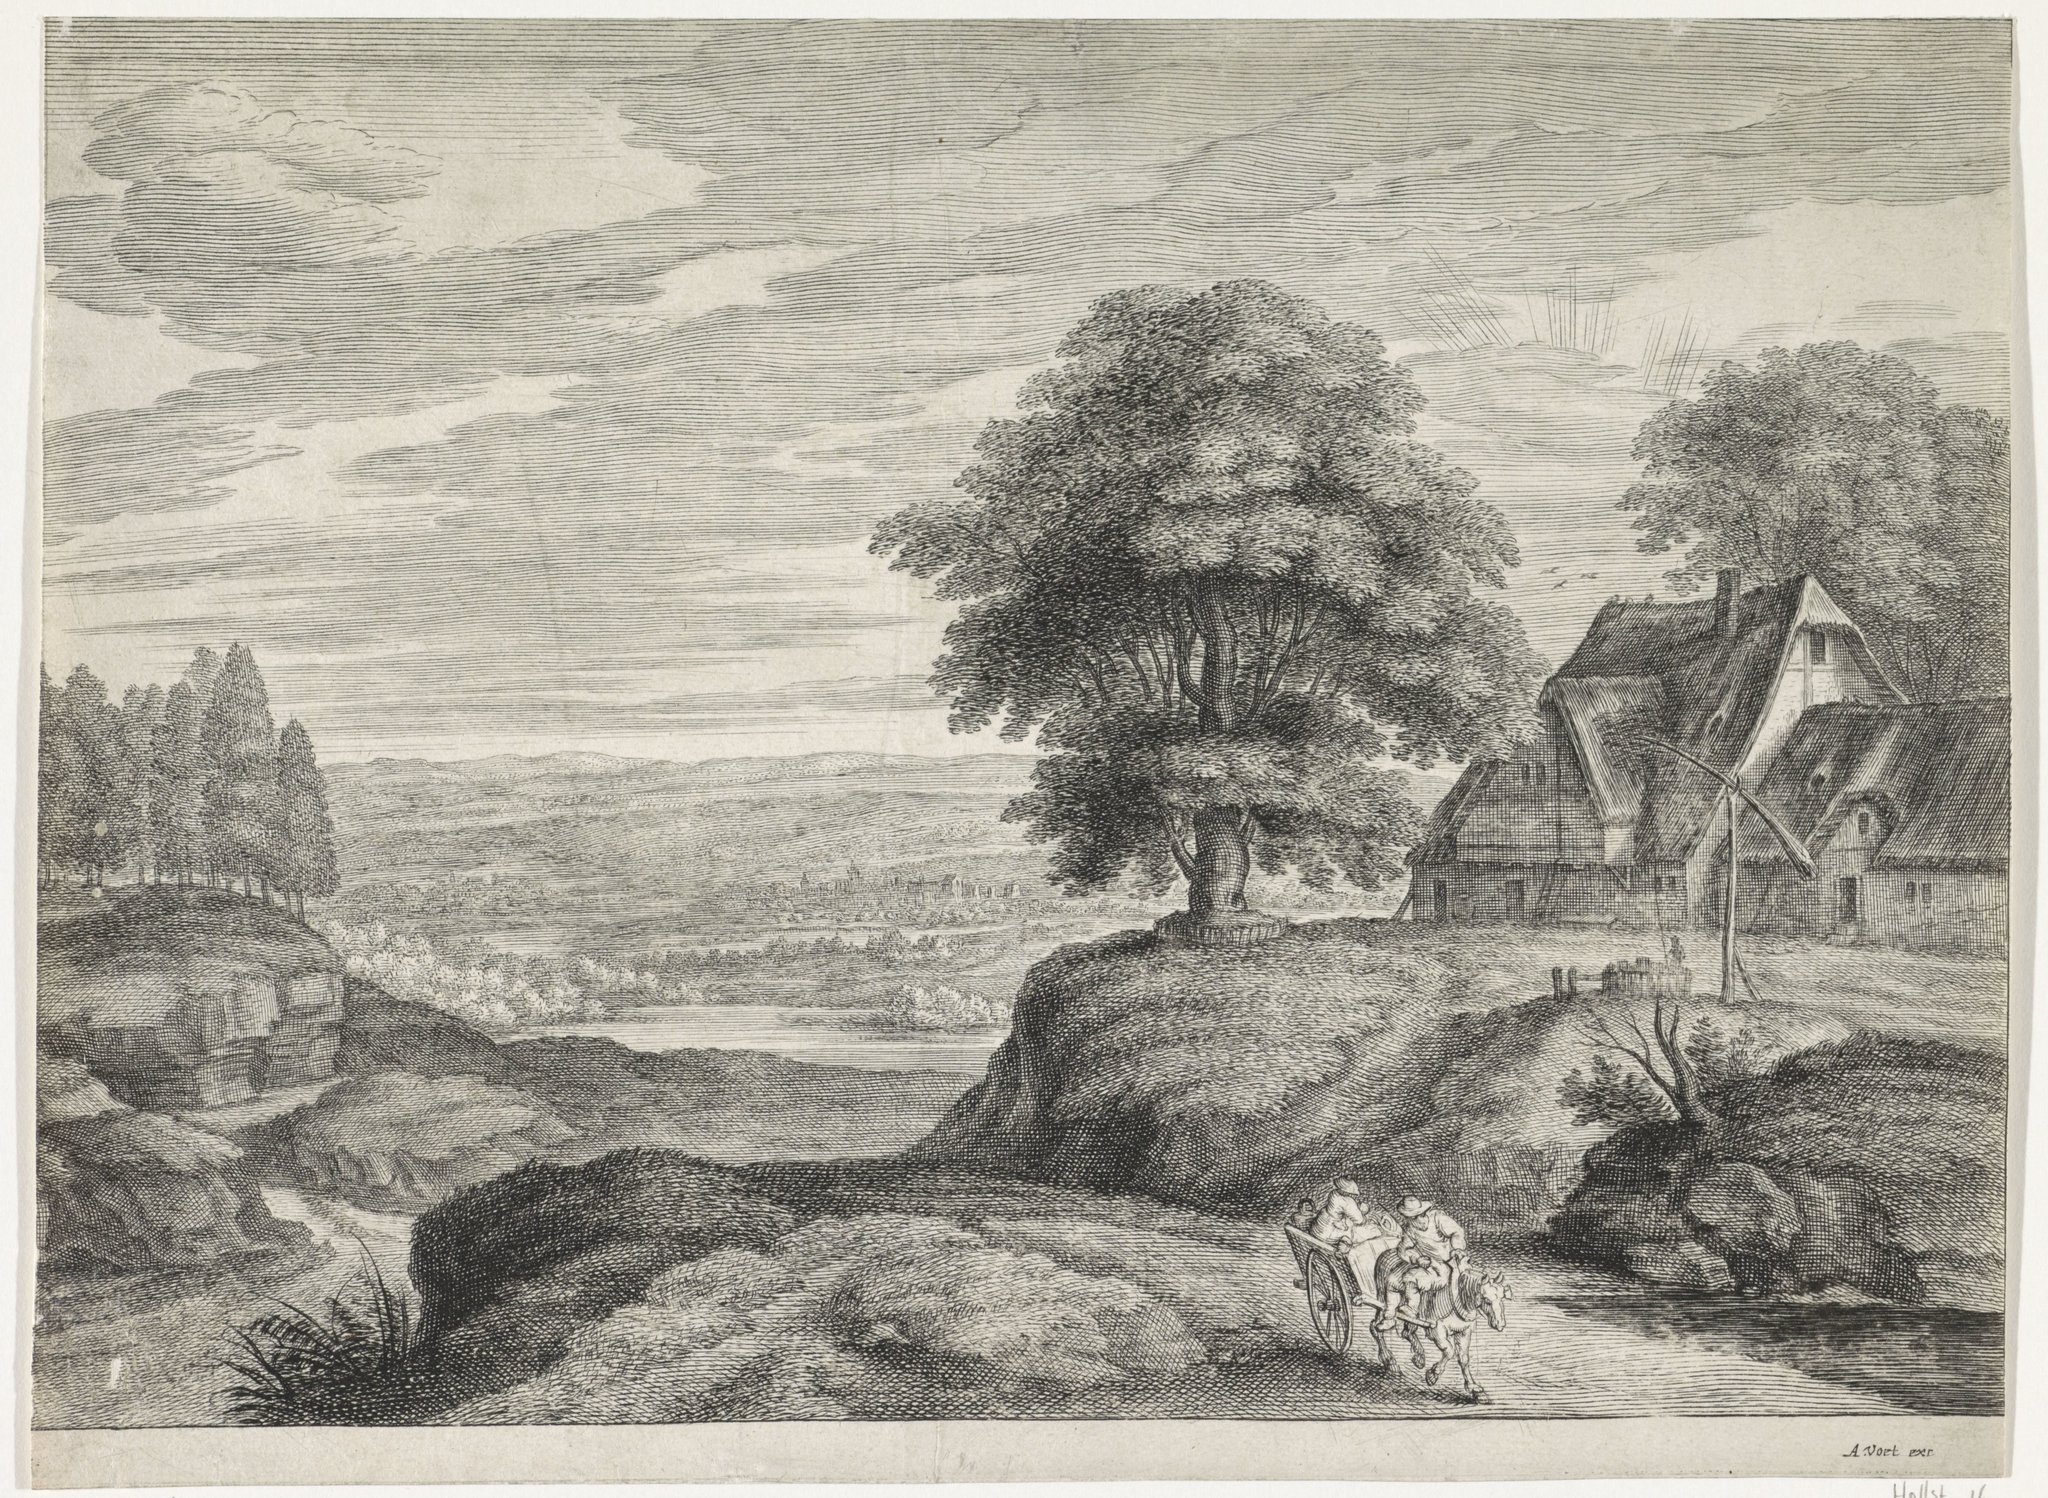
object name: print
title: Landschap met boerenkar bij boerderij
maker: alexander voet (ii)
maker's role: print maker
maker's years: 1635-1695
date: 1661-1689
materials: paper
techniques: engraving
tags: well, dale, valley, farm or solitary house in landscape (+ city(-scape) with figures, staffage), farm or solitary house in landscape, (farm) wagon, freight wagon, cart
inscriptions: collector's mark: Lugt 2228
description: Heuvellandschap met rechts een boerderij, op de voorgrond een boerenkar en op de achtergrond een gezicht op een dal. Voor de boerderij een waterput.